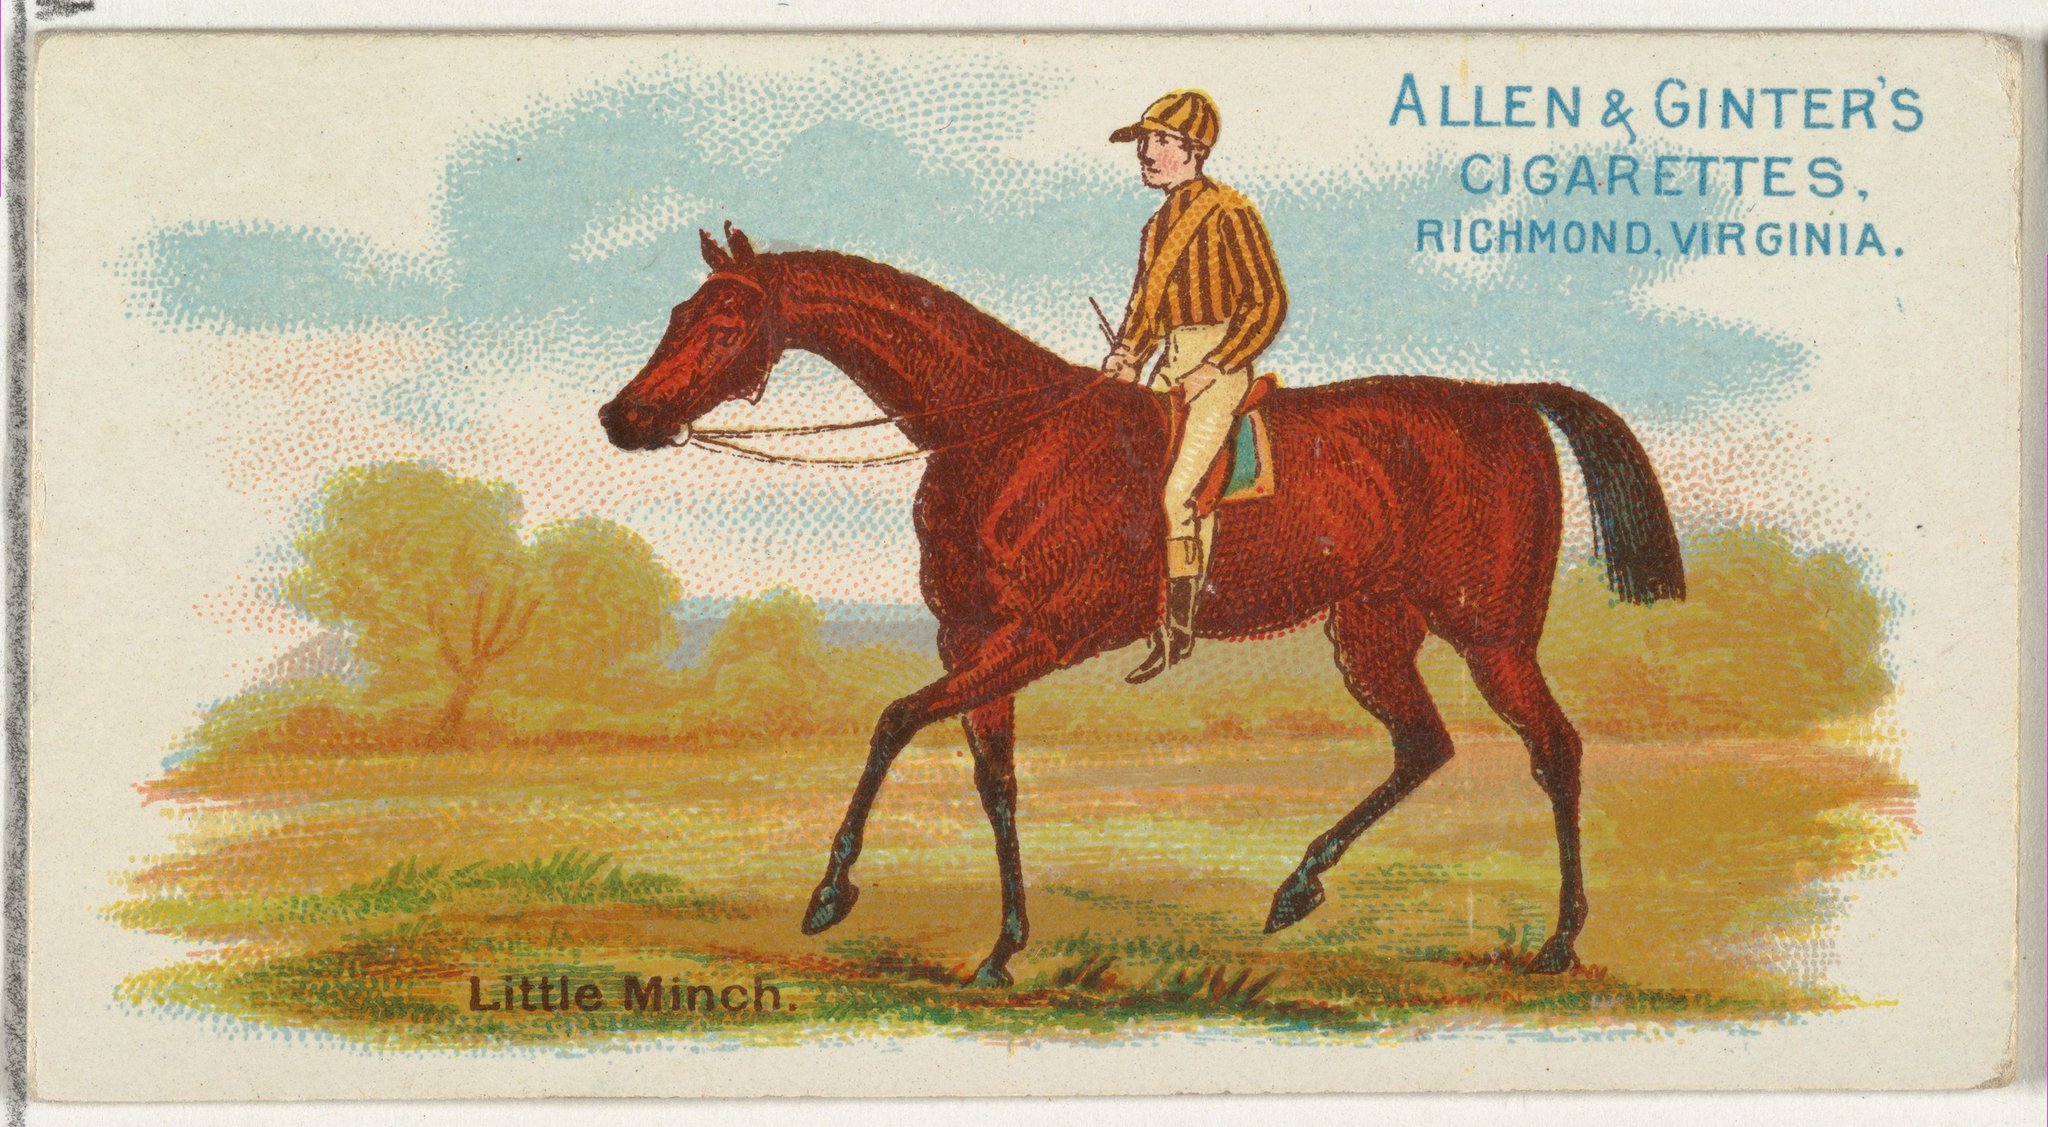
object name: print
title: Little Minch, from The World's Racers series (N32) for Allen & Ginter Cigarettes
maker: allen & ginter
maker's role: publisher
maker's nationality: american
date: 1888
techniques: color lithograph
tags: men,horses,jockeys